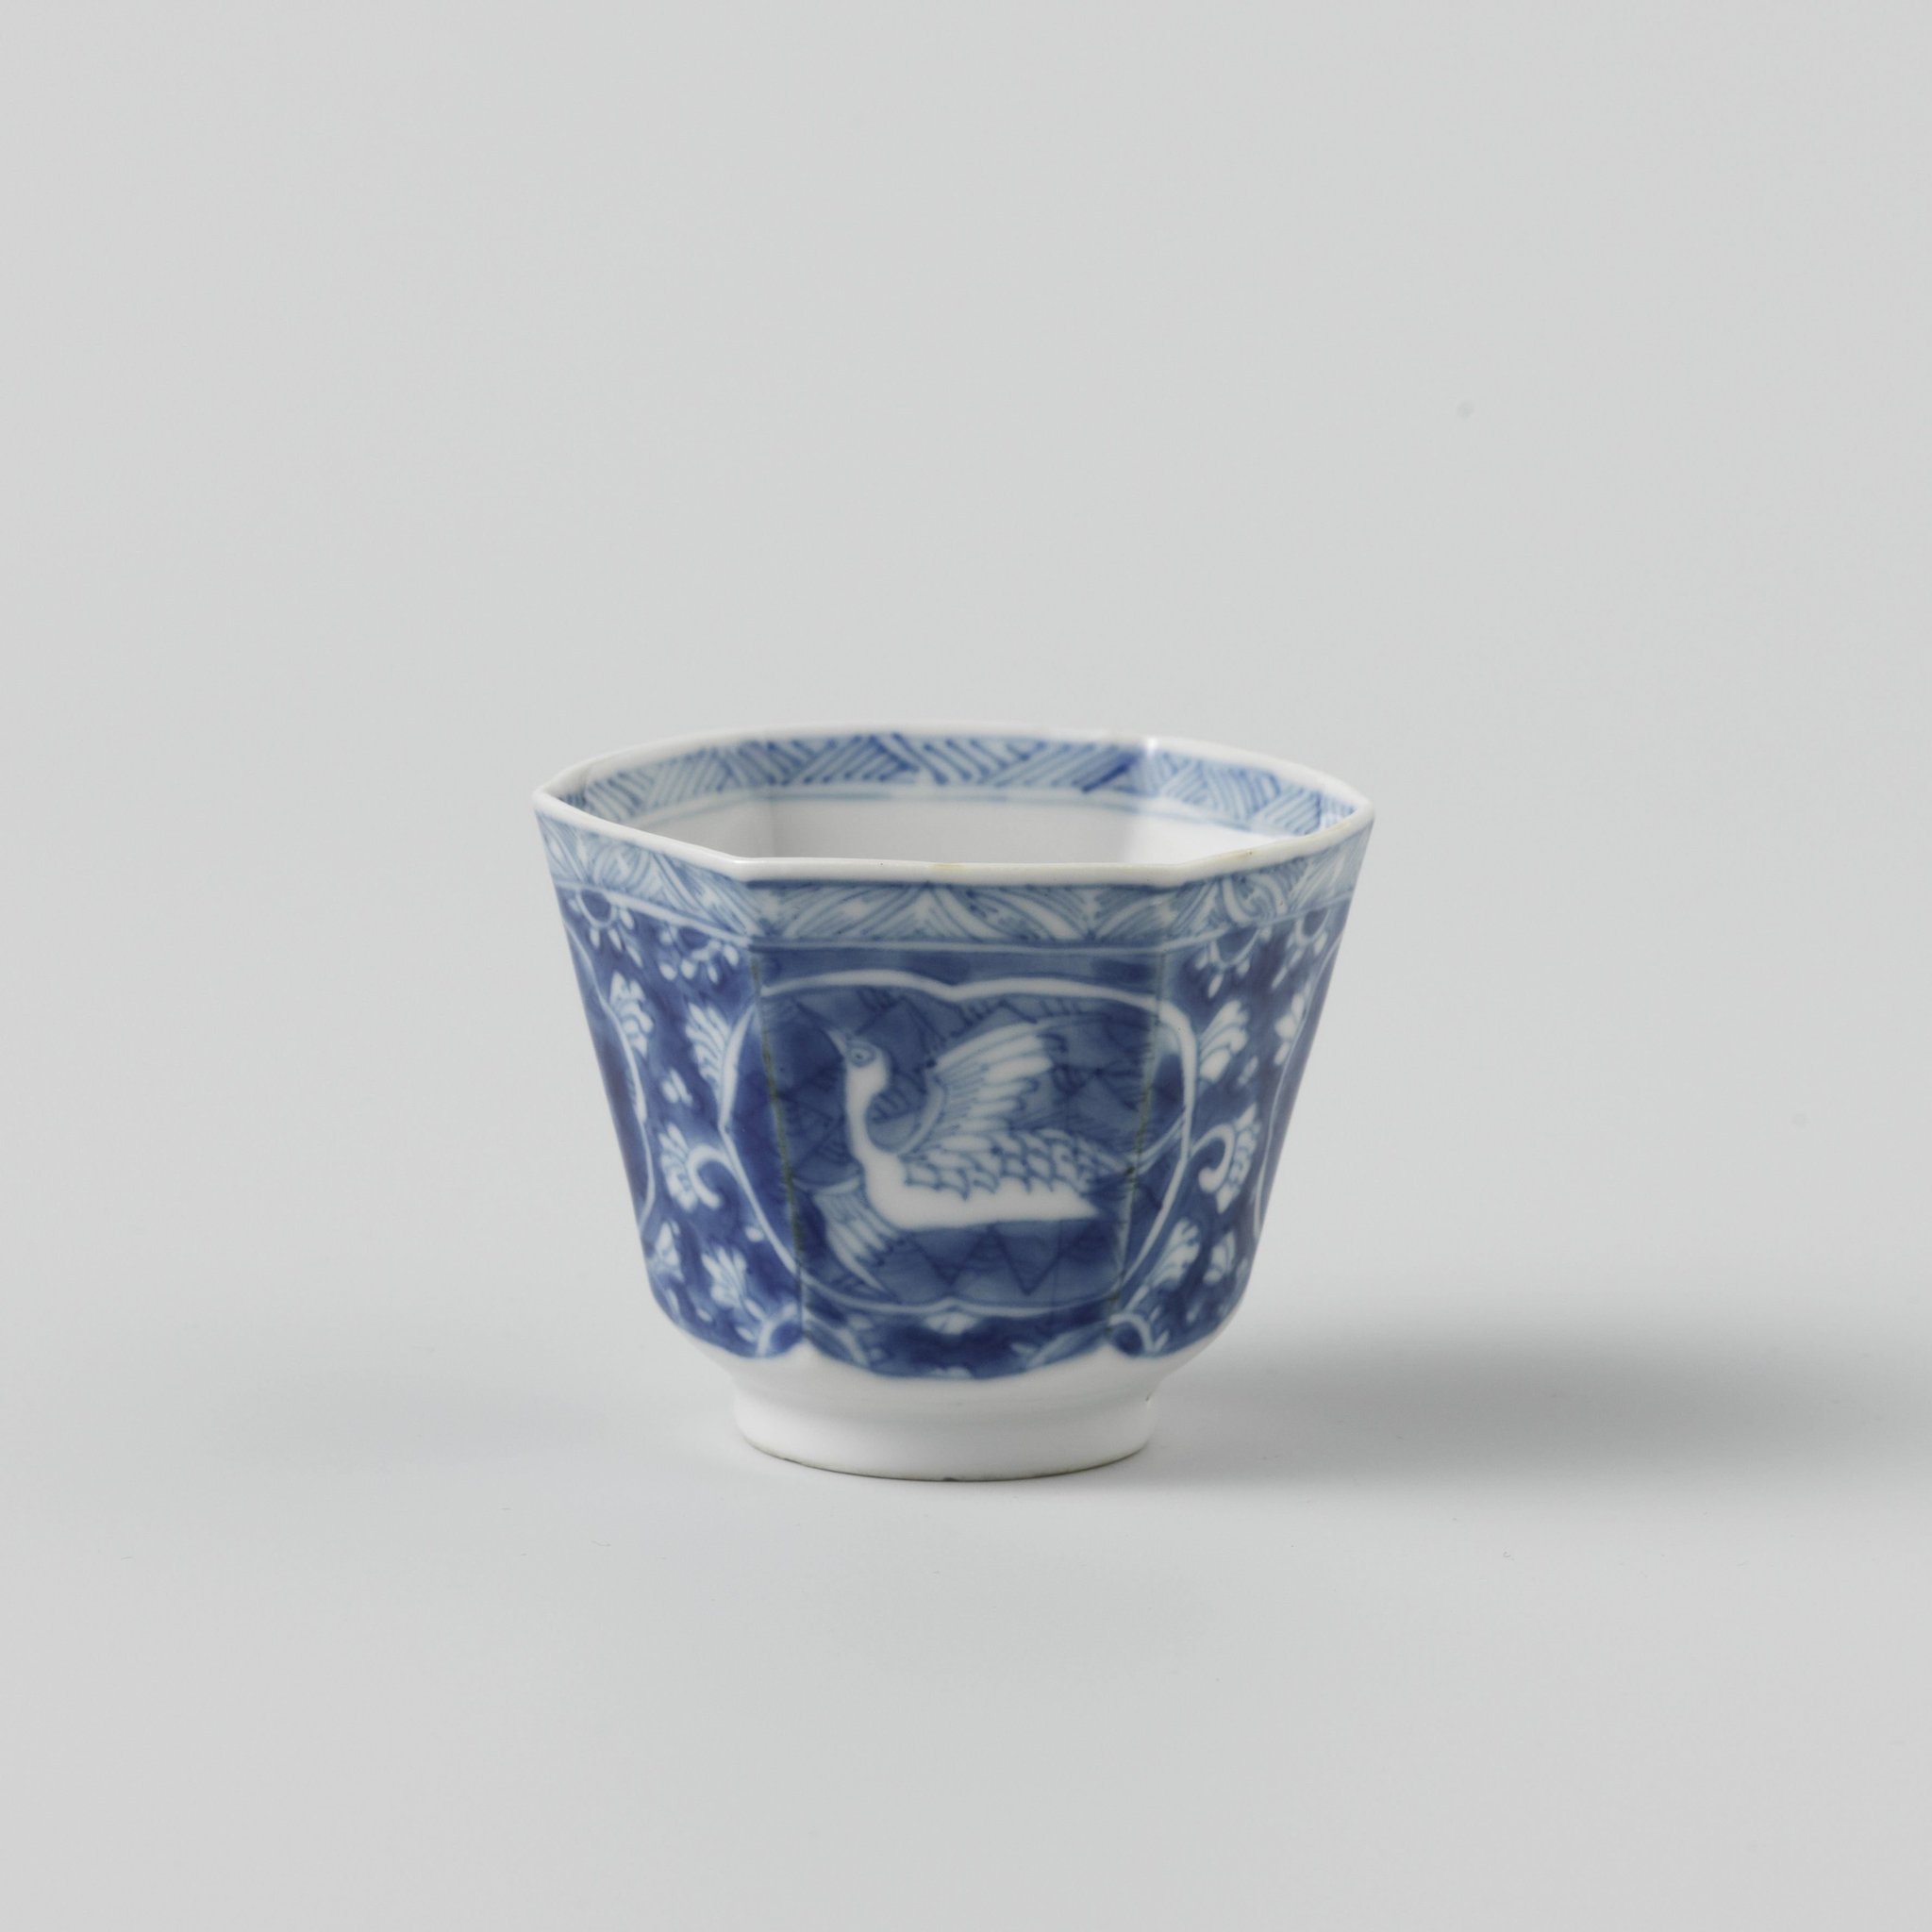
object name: cup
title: Hexagonal cup with a flying crane in a panel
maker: Anonymous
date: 1700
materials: cobalt, glaze, paint, porcelain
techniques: firing, forming, turning, vitrification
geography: china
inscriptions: mark: ‘福’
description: The drinking of tea was increasingly adopted in the West by the end of the 17th century. China had been closed for decades as the result of a civil war. When it ended, VOC merchants could once again buy porcelain from China, and the supply of tea and of teacups grew enormously. The hexagonal form of these cups is exceptional, just as is the crane in flight, set against a richly variegated blue background.